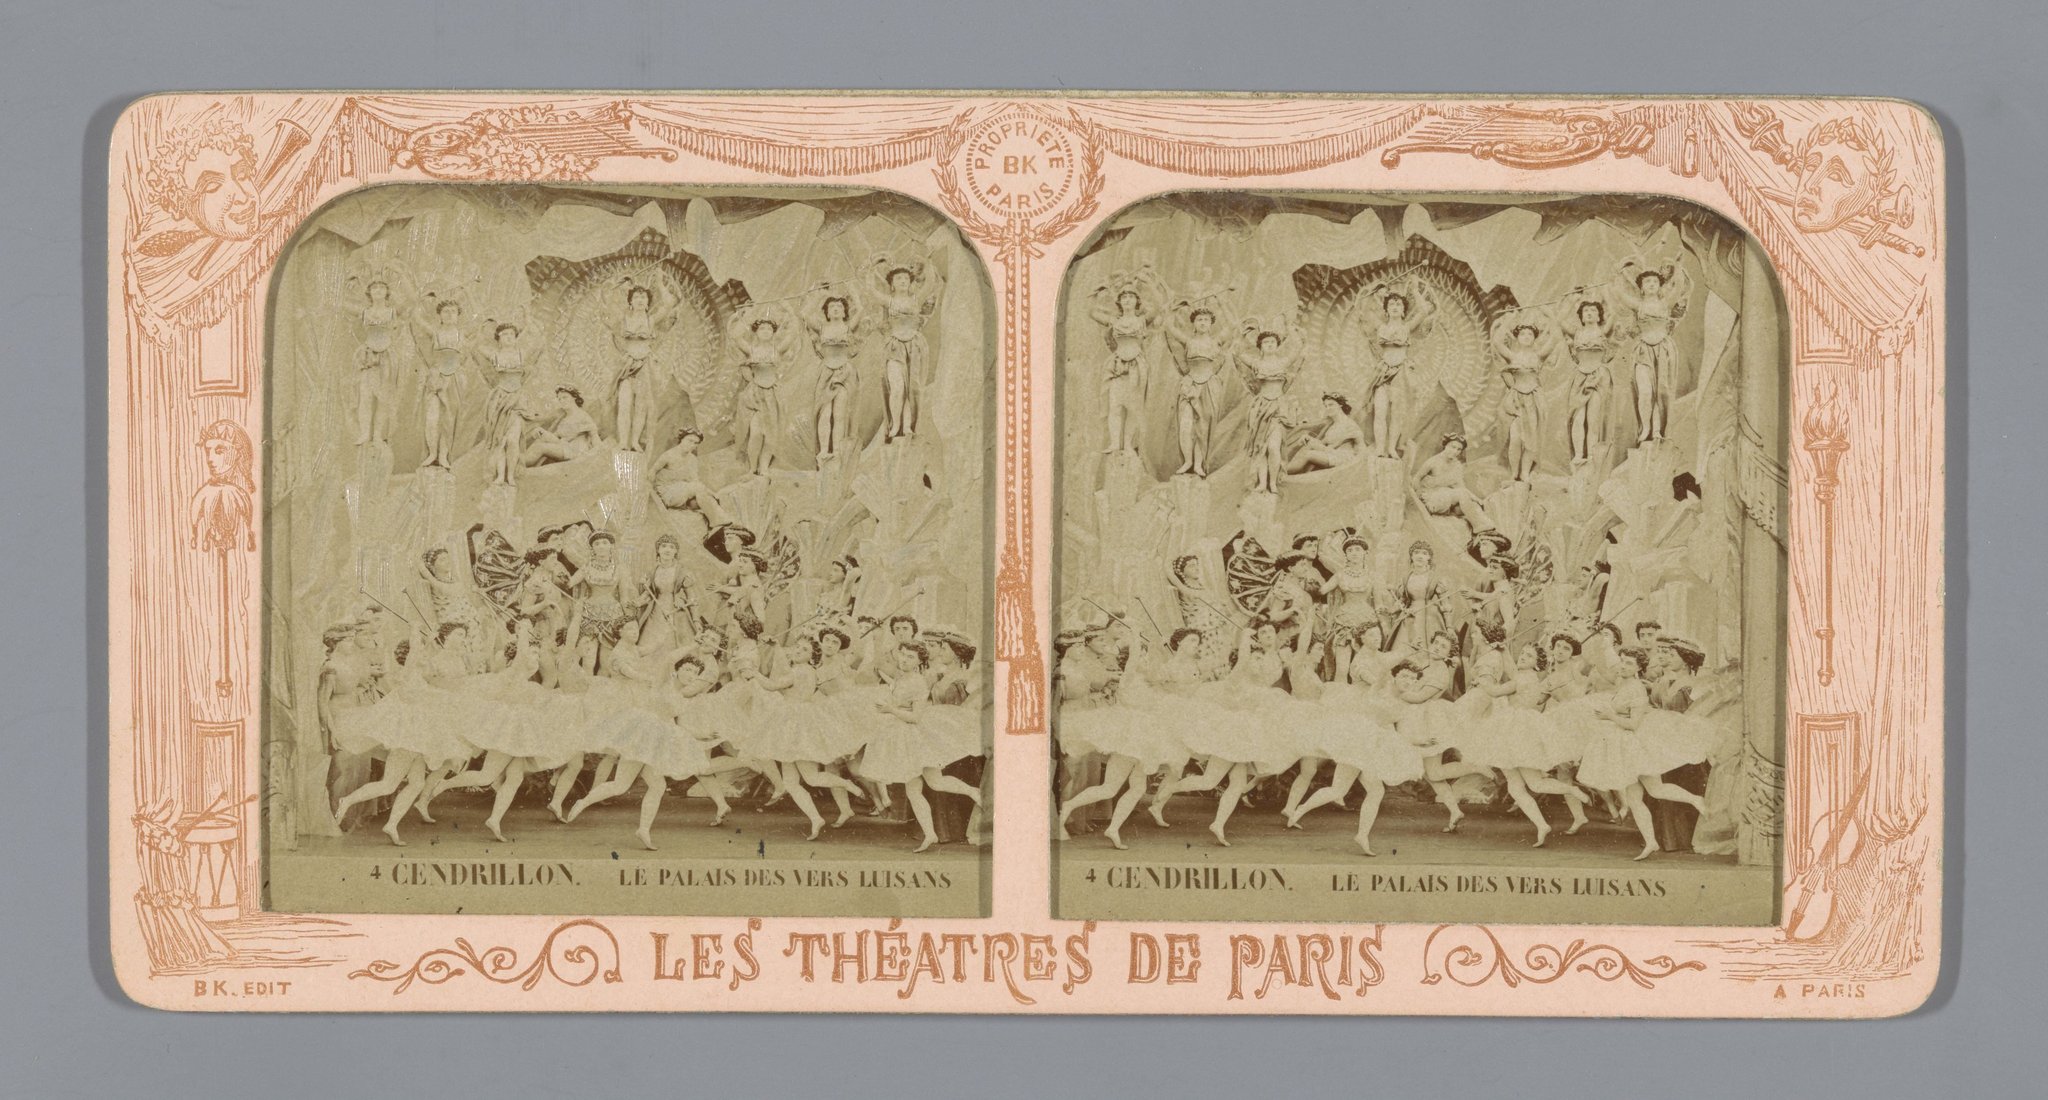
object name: tissue stereograph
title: Le Palais des Vers Luisans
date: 1867-1967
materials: cardboard, paper, photographic support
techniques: albumen print, cutting, hand coloring, perforating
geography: paris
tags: opera, paris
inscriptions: inscription: ‘PROPRIETE/ BK/ PARIS’, number: ‘4’